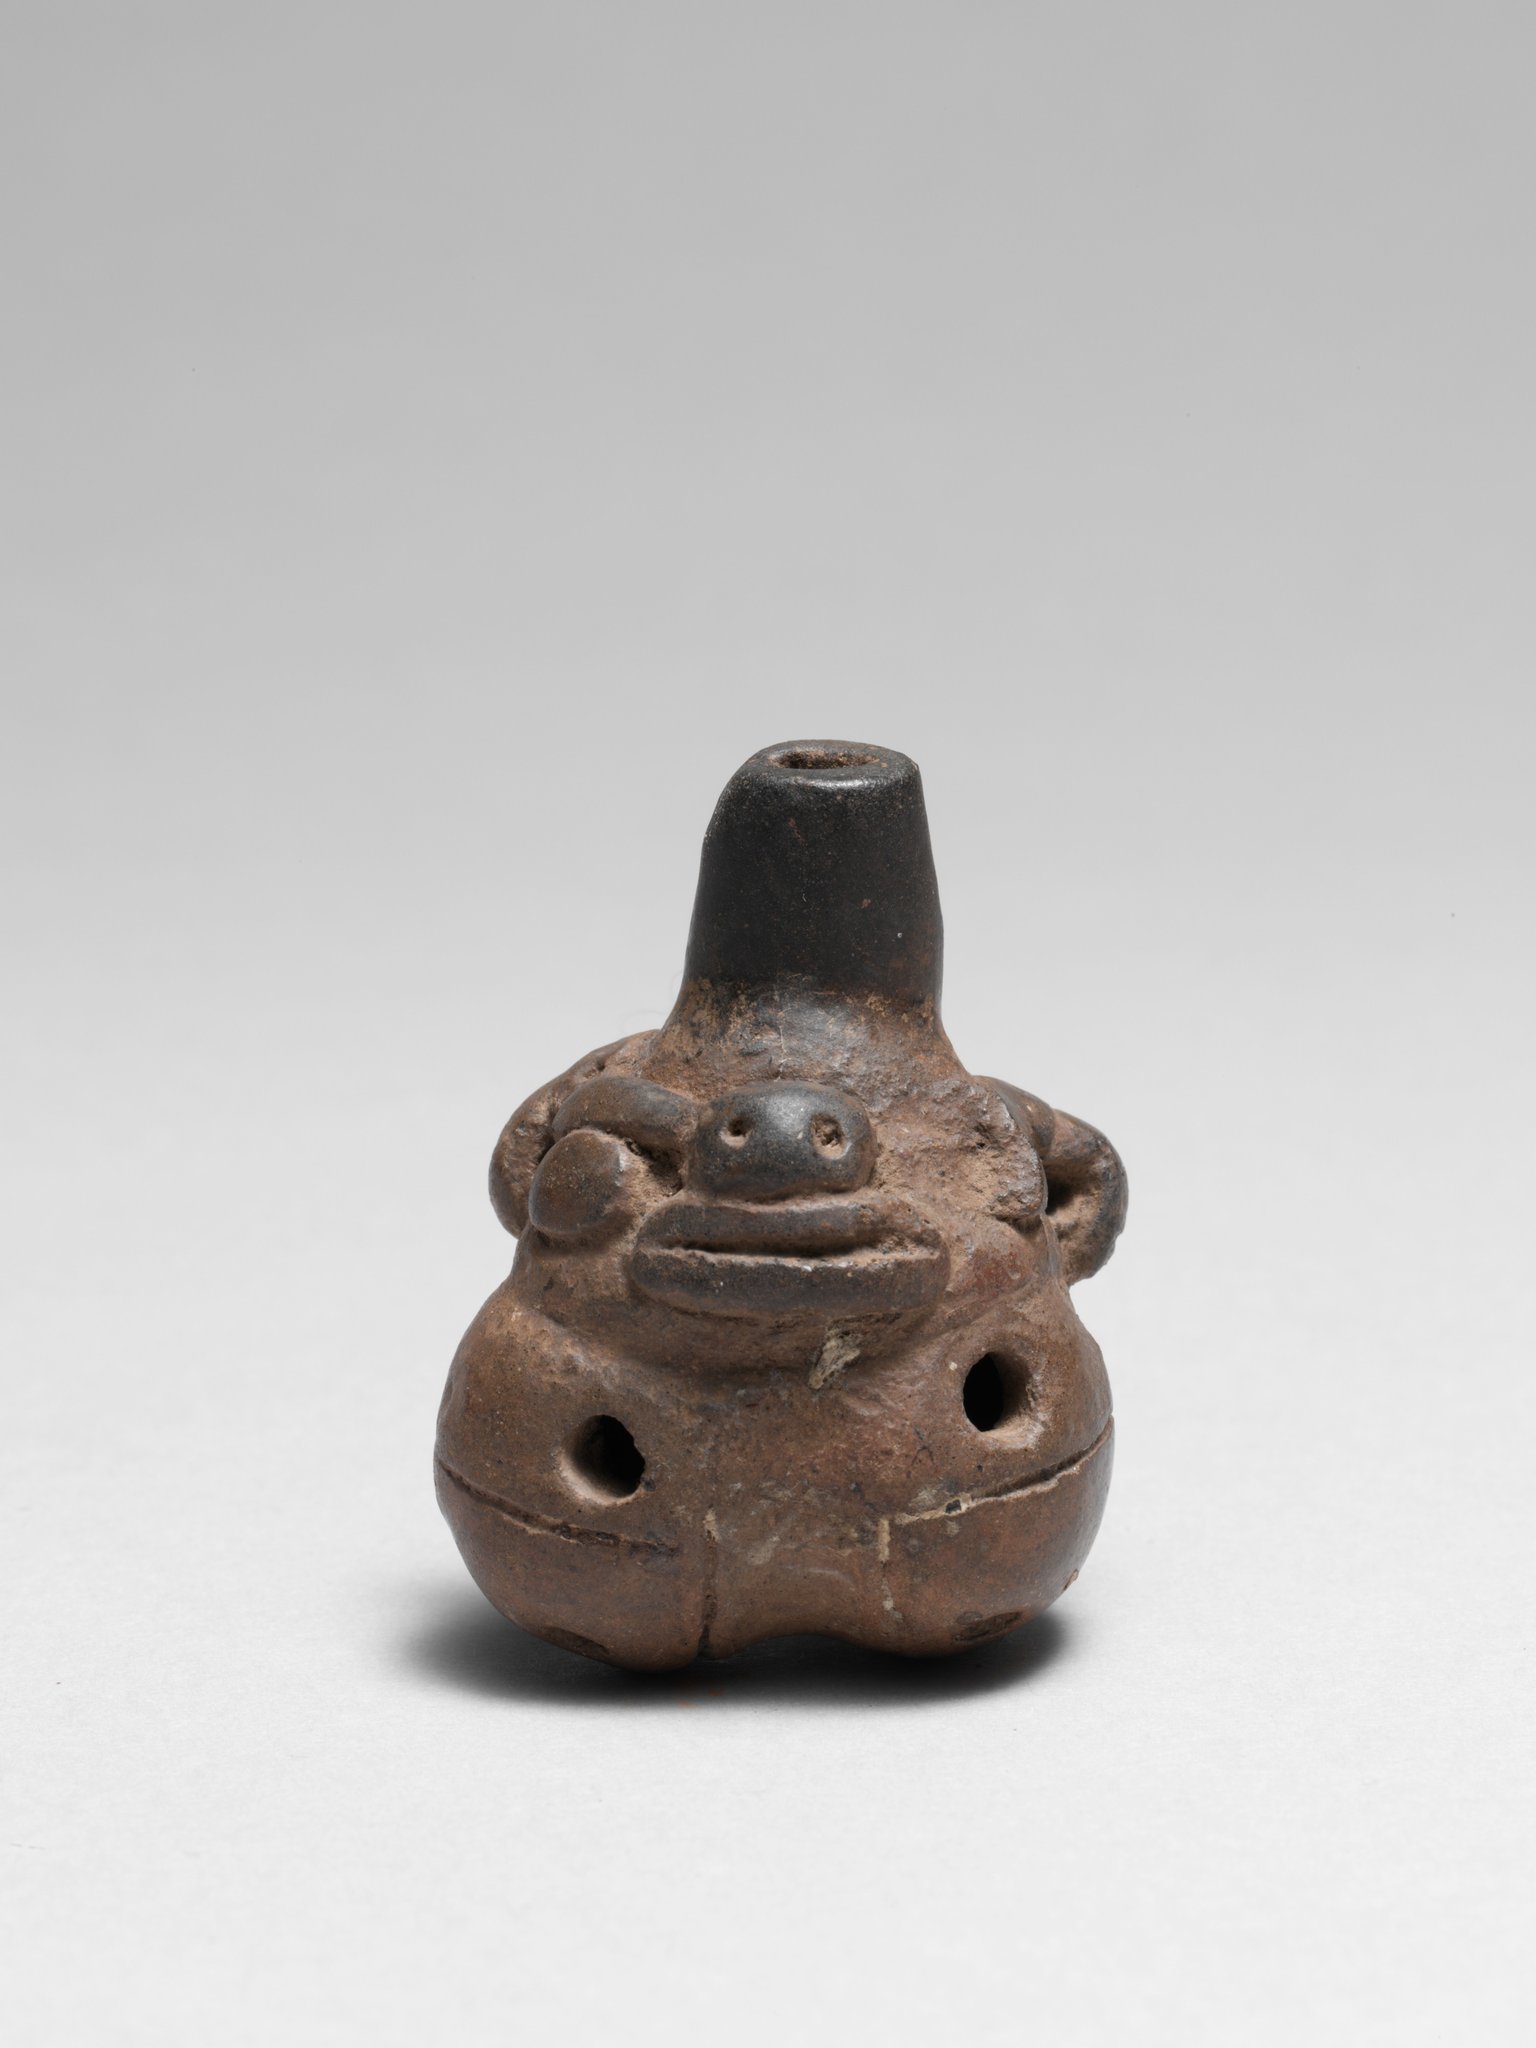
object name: pottery whistle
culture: costa rican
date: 1501-1600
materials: clay